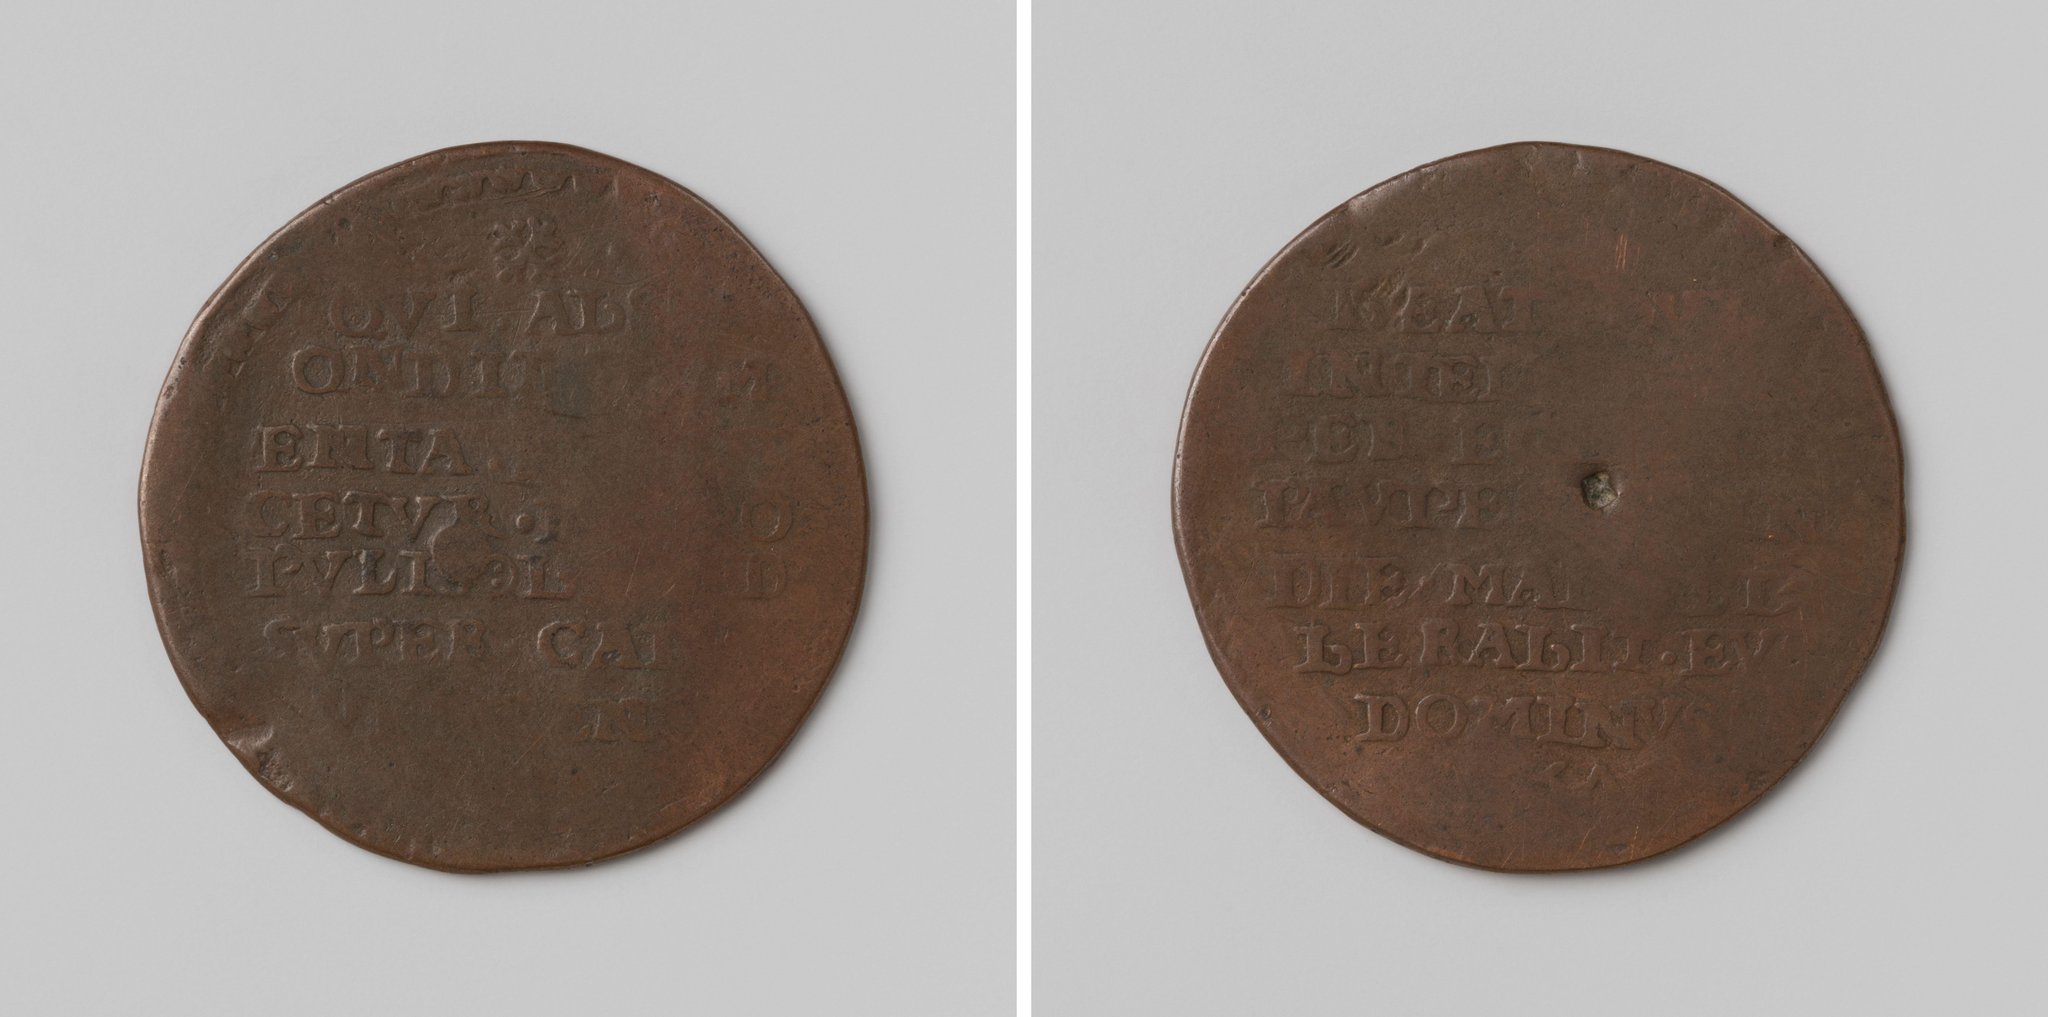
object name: jeton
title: Duurte van graan in de Nederlanden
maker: Anonymous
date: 1557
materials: copper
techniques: striking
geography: netherlands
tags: netherlands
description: Koperen penning. Voorzijde: opschrift binnen sierrand. Keerzijde: opschrift binnen sierrand.